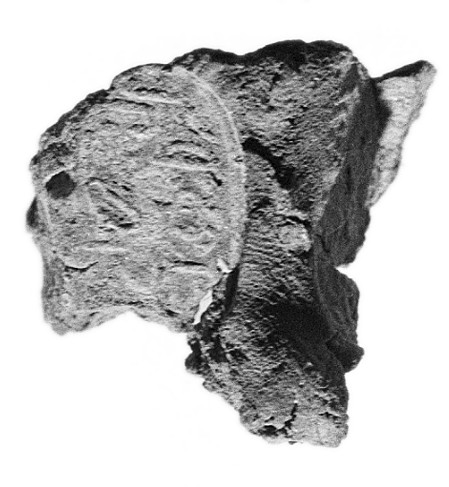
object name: sealing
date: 1981-1640 BCE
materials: mud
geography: egypt